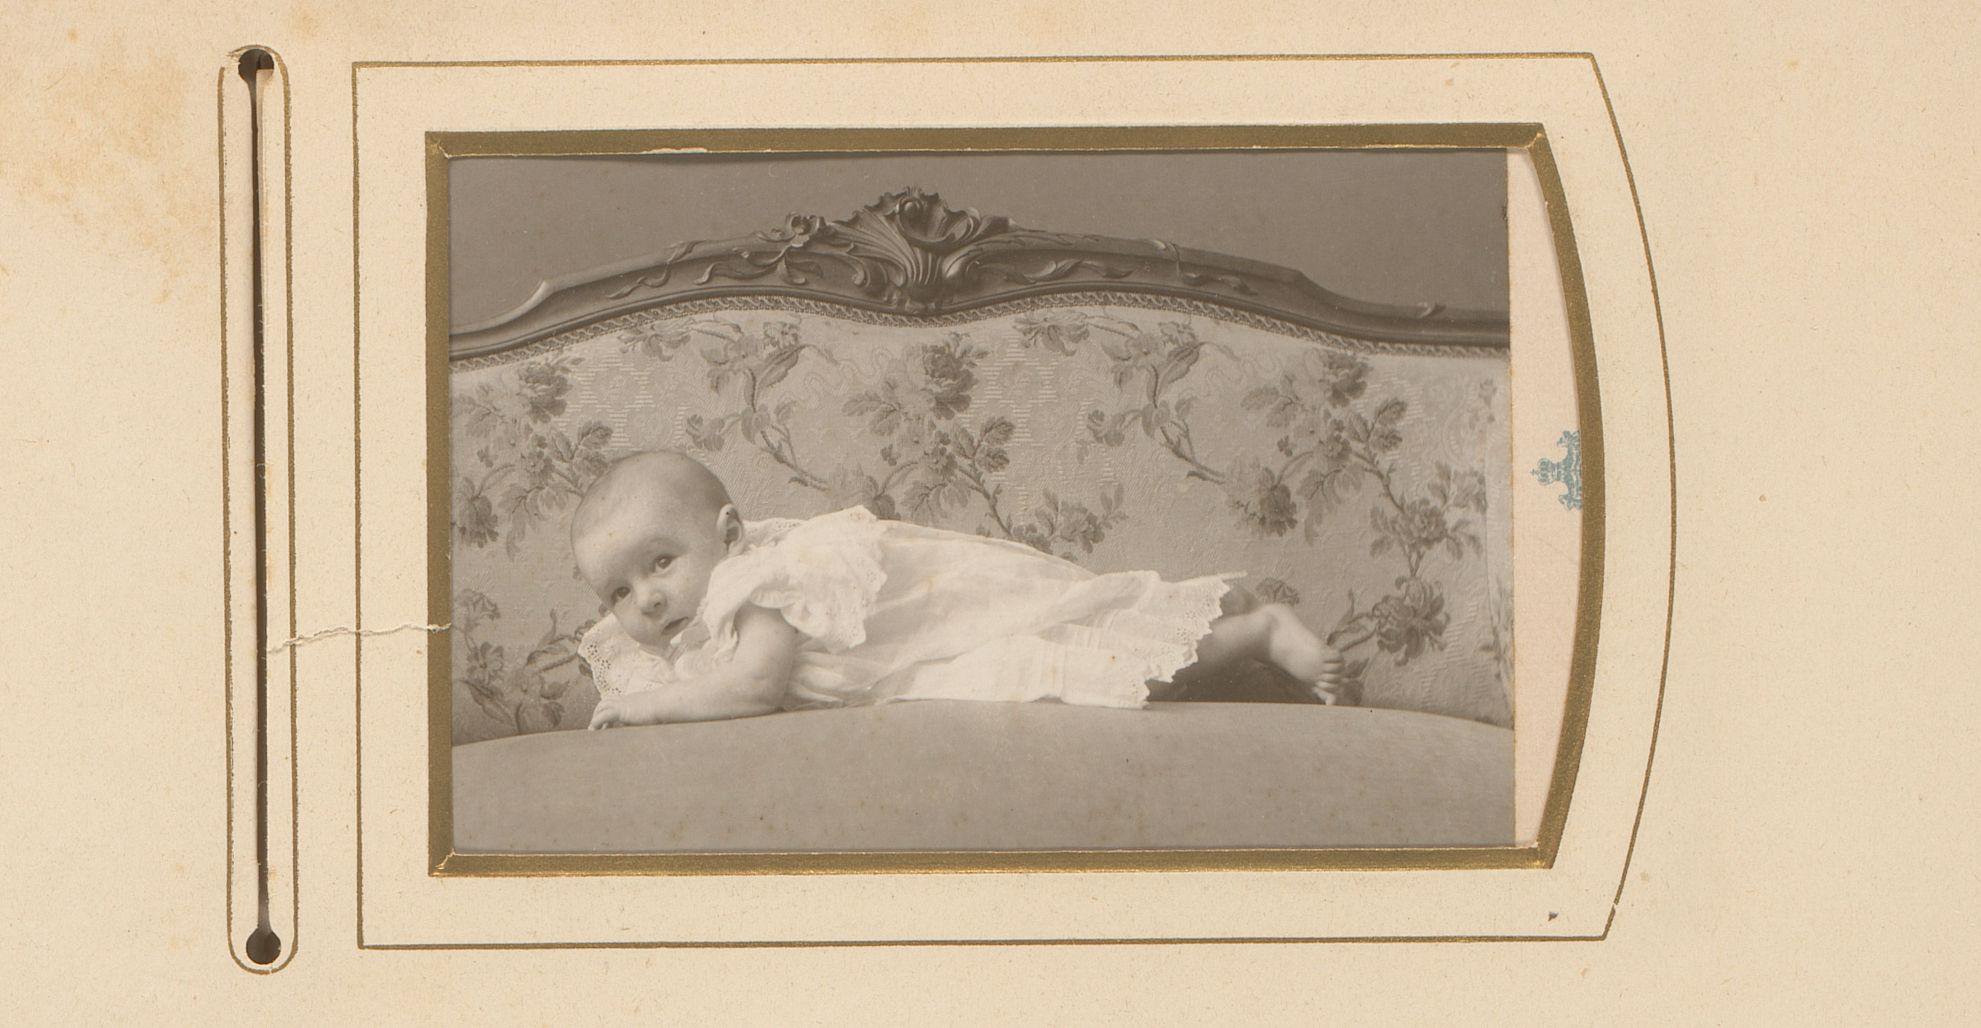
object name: album leaf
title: Portret van een baby, liggend op bank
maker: albert greiner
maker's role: fotograaf, fotostudio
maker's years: 1833-1890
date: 1883-1887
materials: cardboard, photographic support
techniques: collodion silver print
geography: amsterdam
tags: historical persons, infant, baby ~ the ages of man, lying figure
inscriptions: inscription: ‘Anno/ 12 weken/ No 2507d/ De plaat blijft bewaard, gelieve bij/ bestellin dit Nummer op te geven./ Albert Greiner/ Fotograaf van wijlen Z.M. den Koning Willem III/ en van H.M. de Koningin Weduwe./ BEKROOND/ Paris 1878/ Amsterdam 1877/ Arnhem 1879/ Amsterdam 1883/ Amsterdam/ Nieuwendijk No. 89./ SPECIALITEIT IN VERGROOTINGEN./ Telefoon No. 2668.’